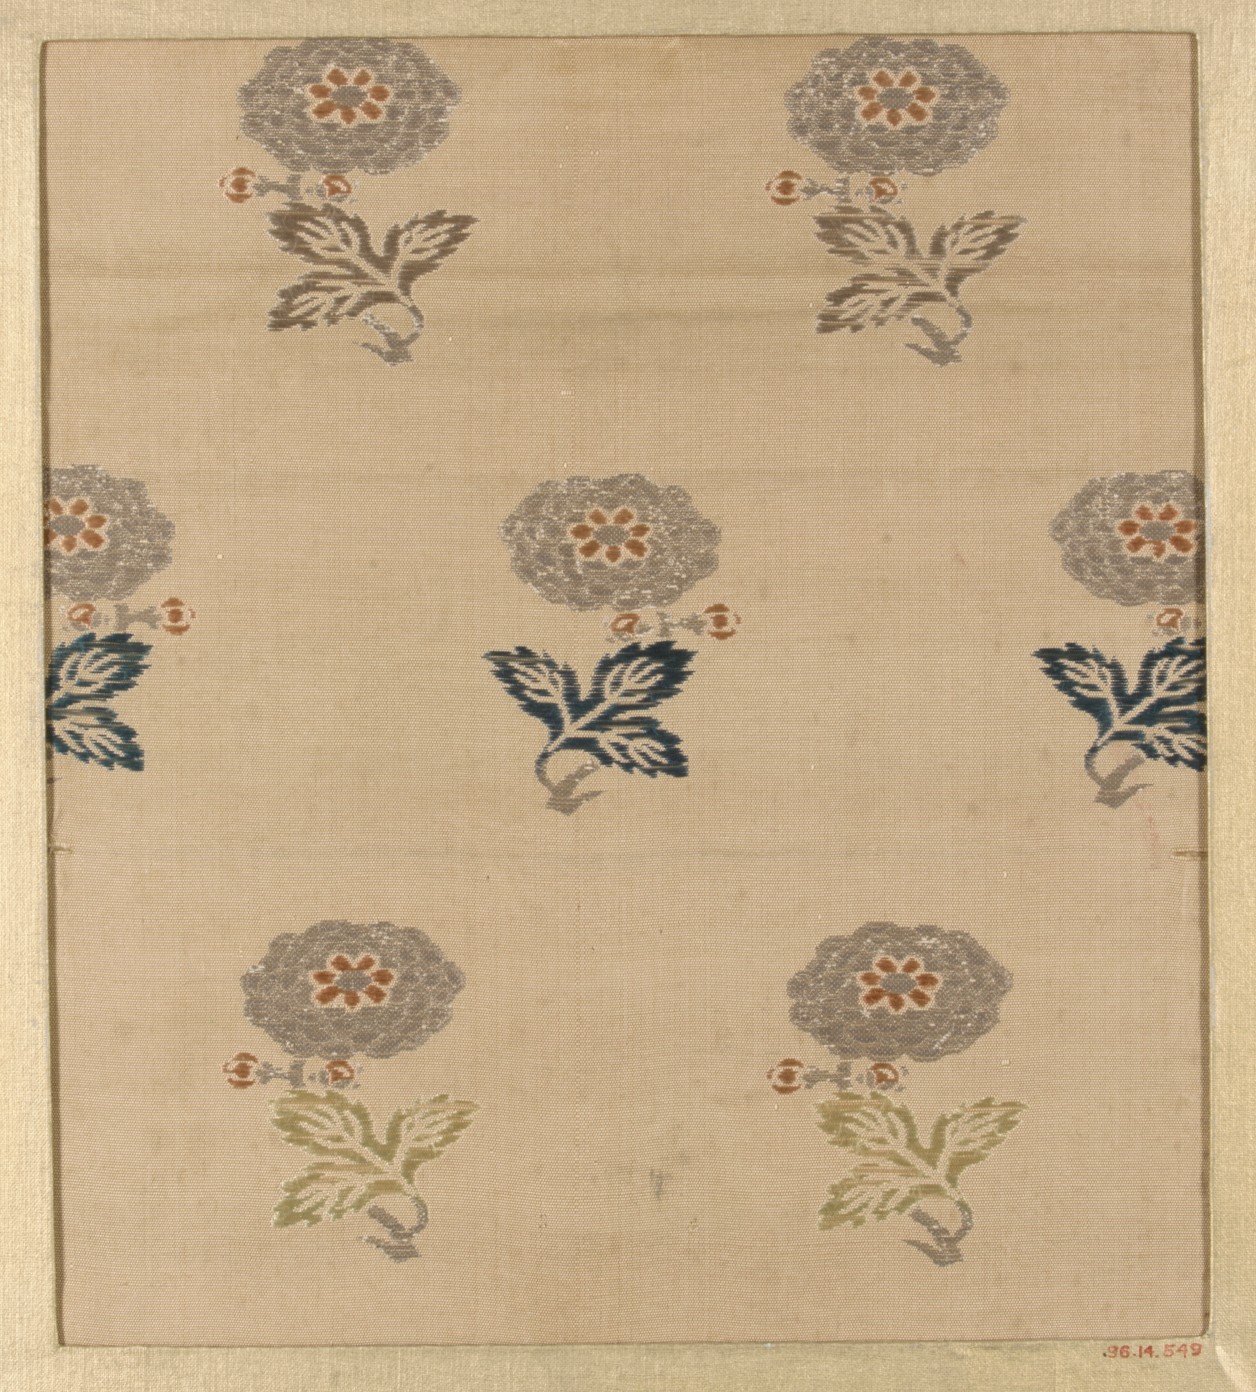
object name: piece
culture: japanese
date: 1701-1900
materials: silk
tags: leaves